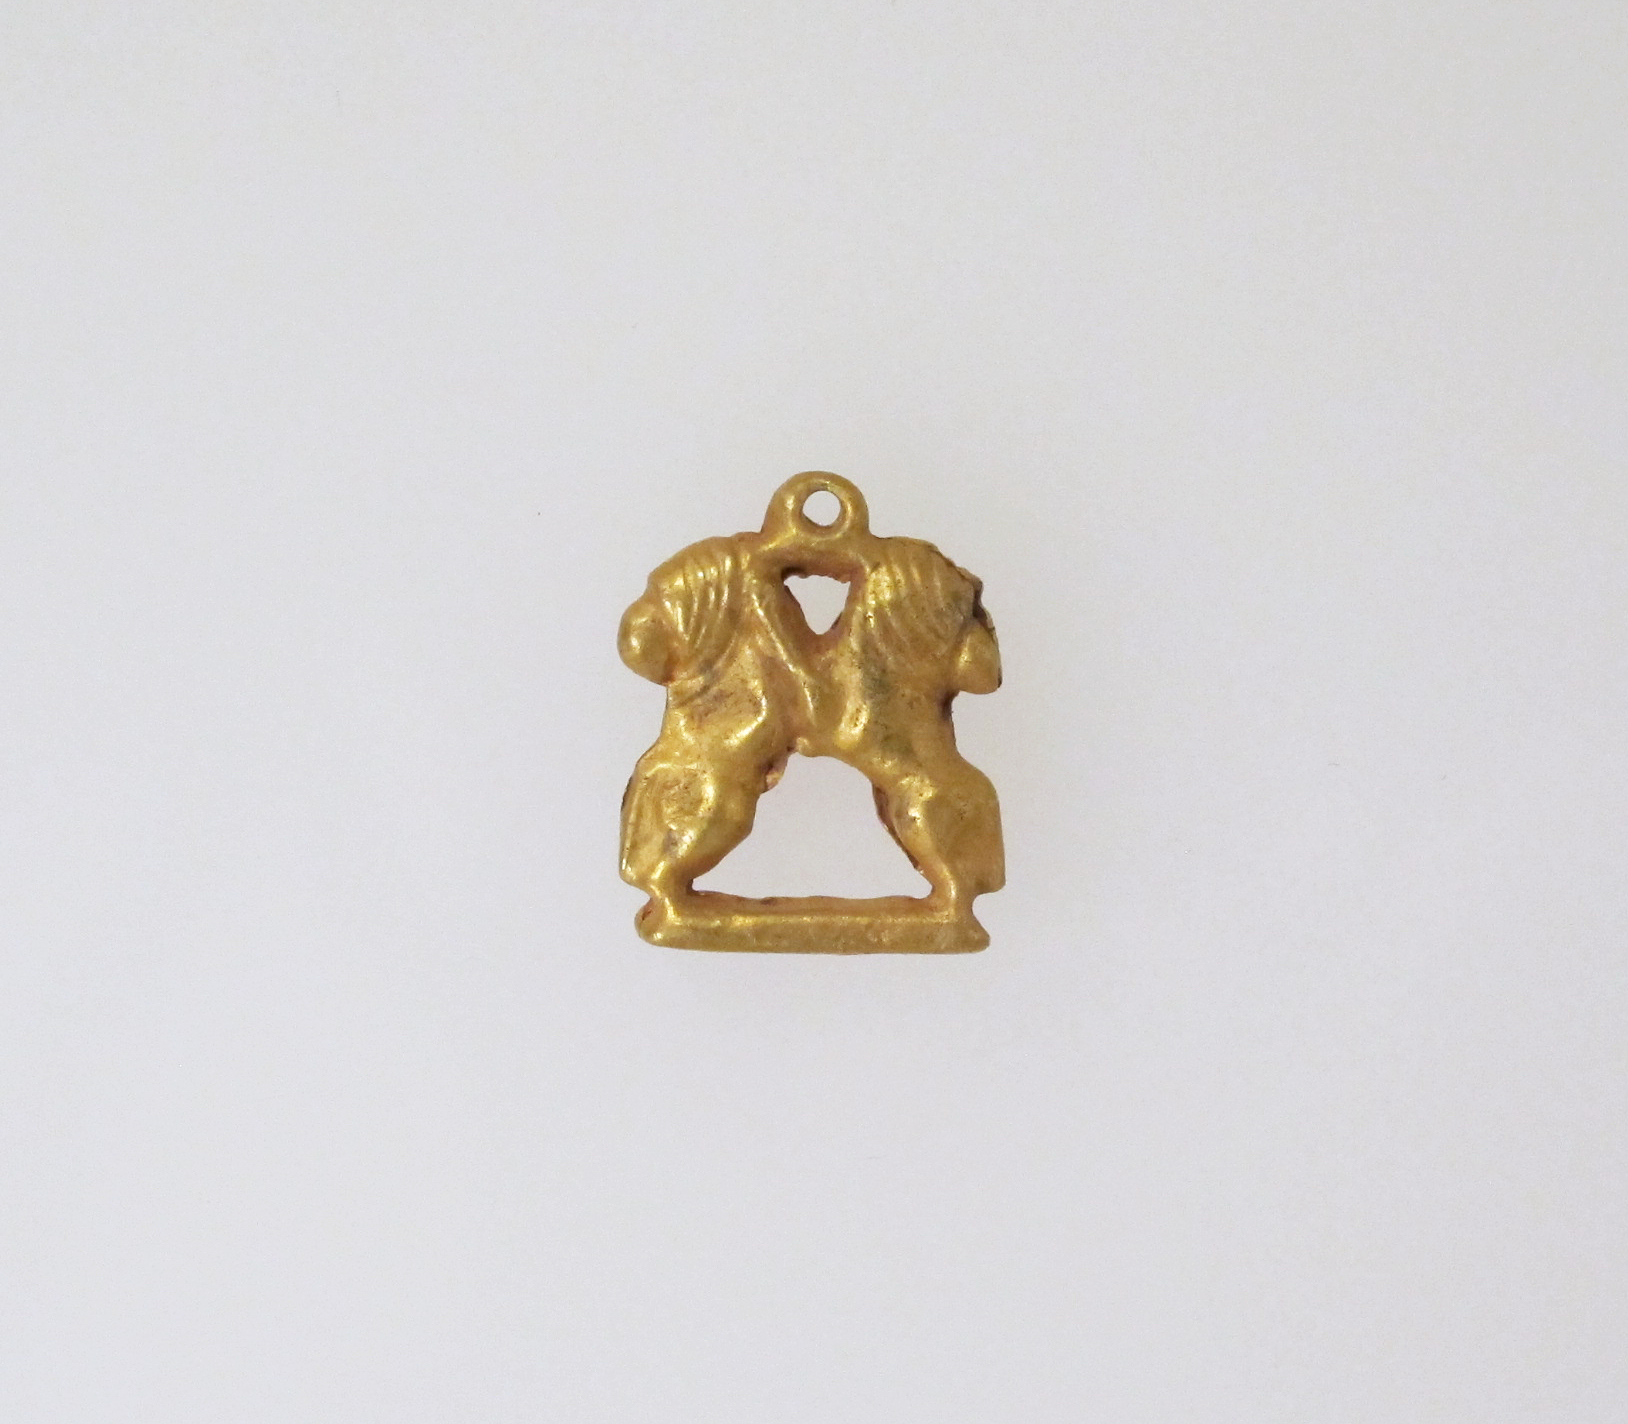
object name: pendant in the form of lion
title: Gold pendant in the form of two rampant lions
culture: minoan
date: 1400-1200 BCE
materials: gold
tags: lions